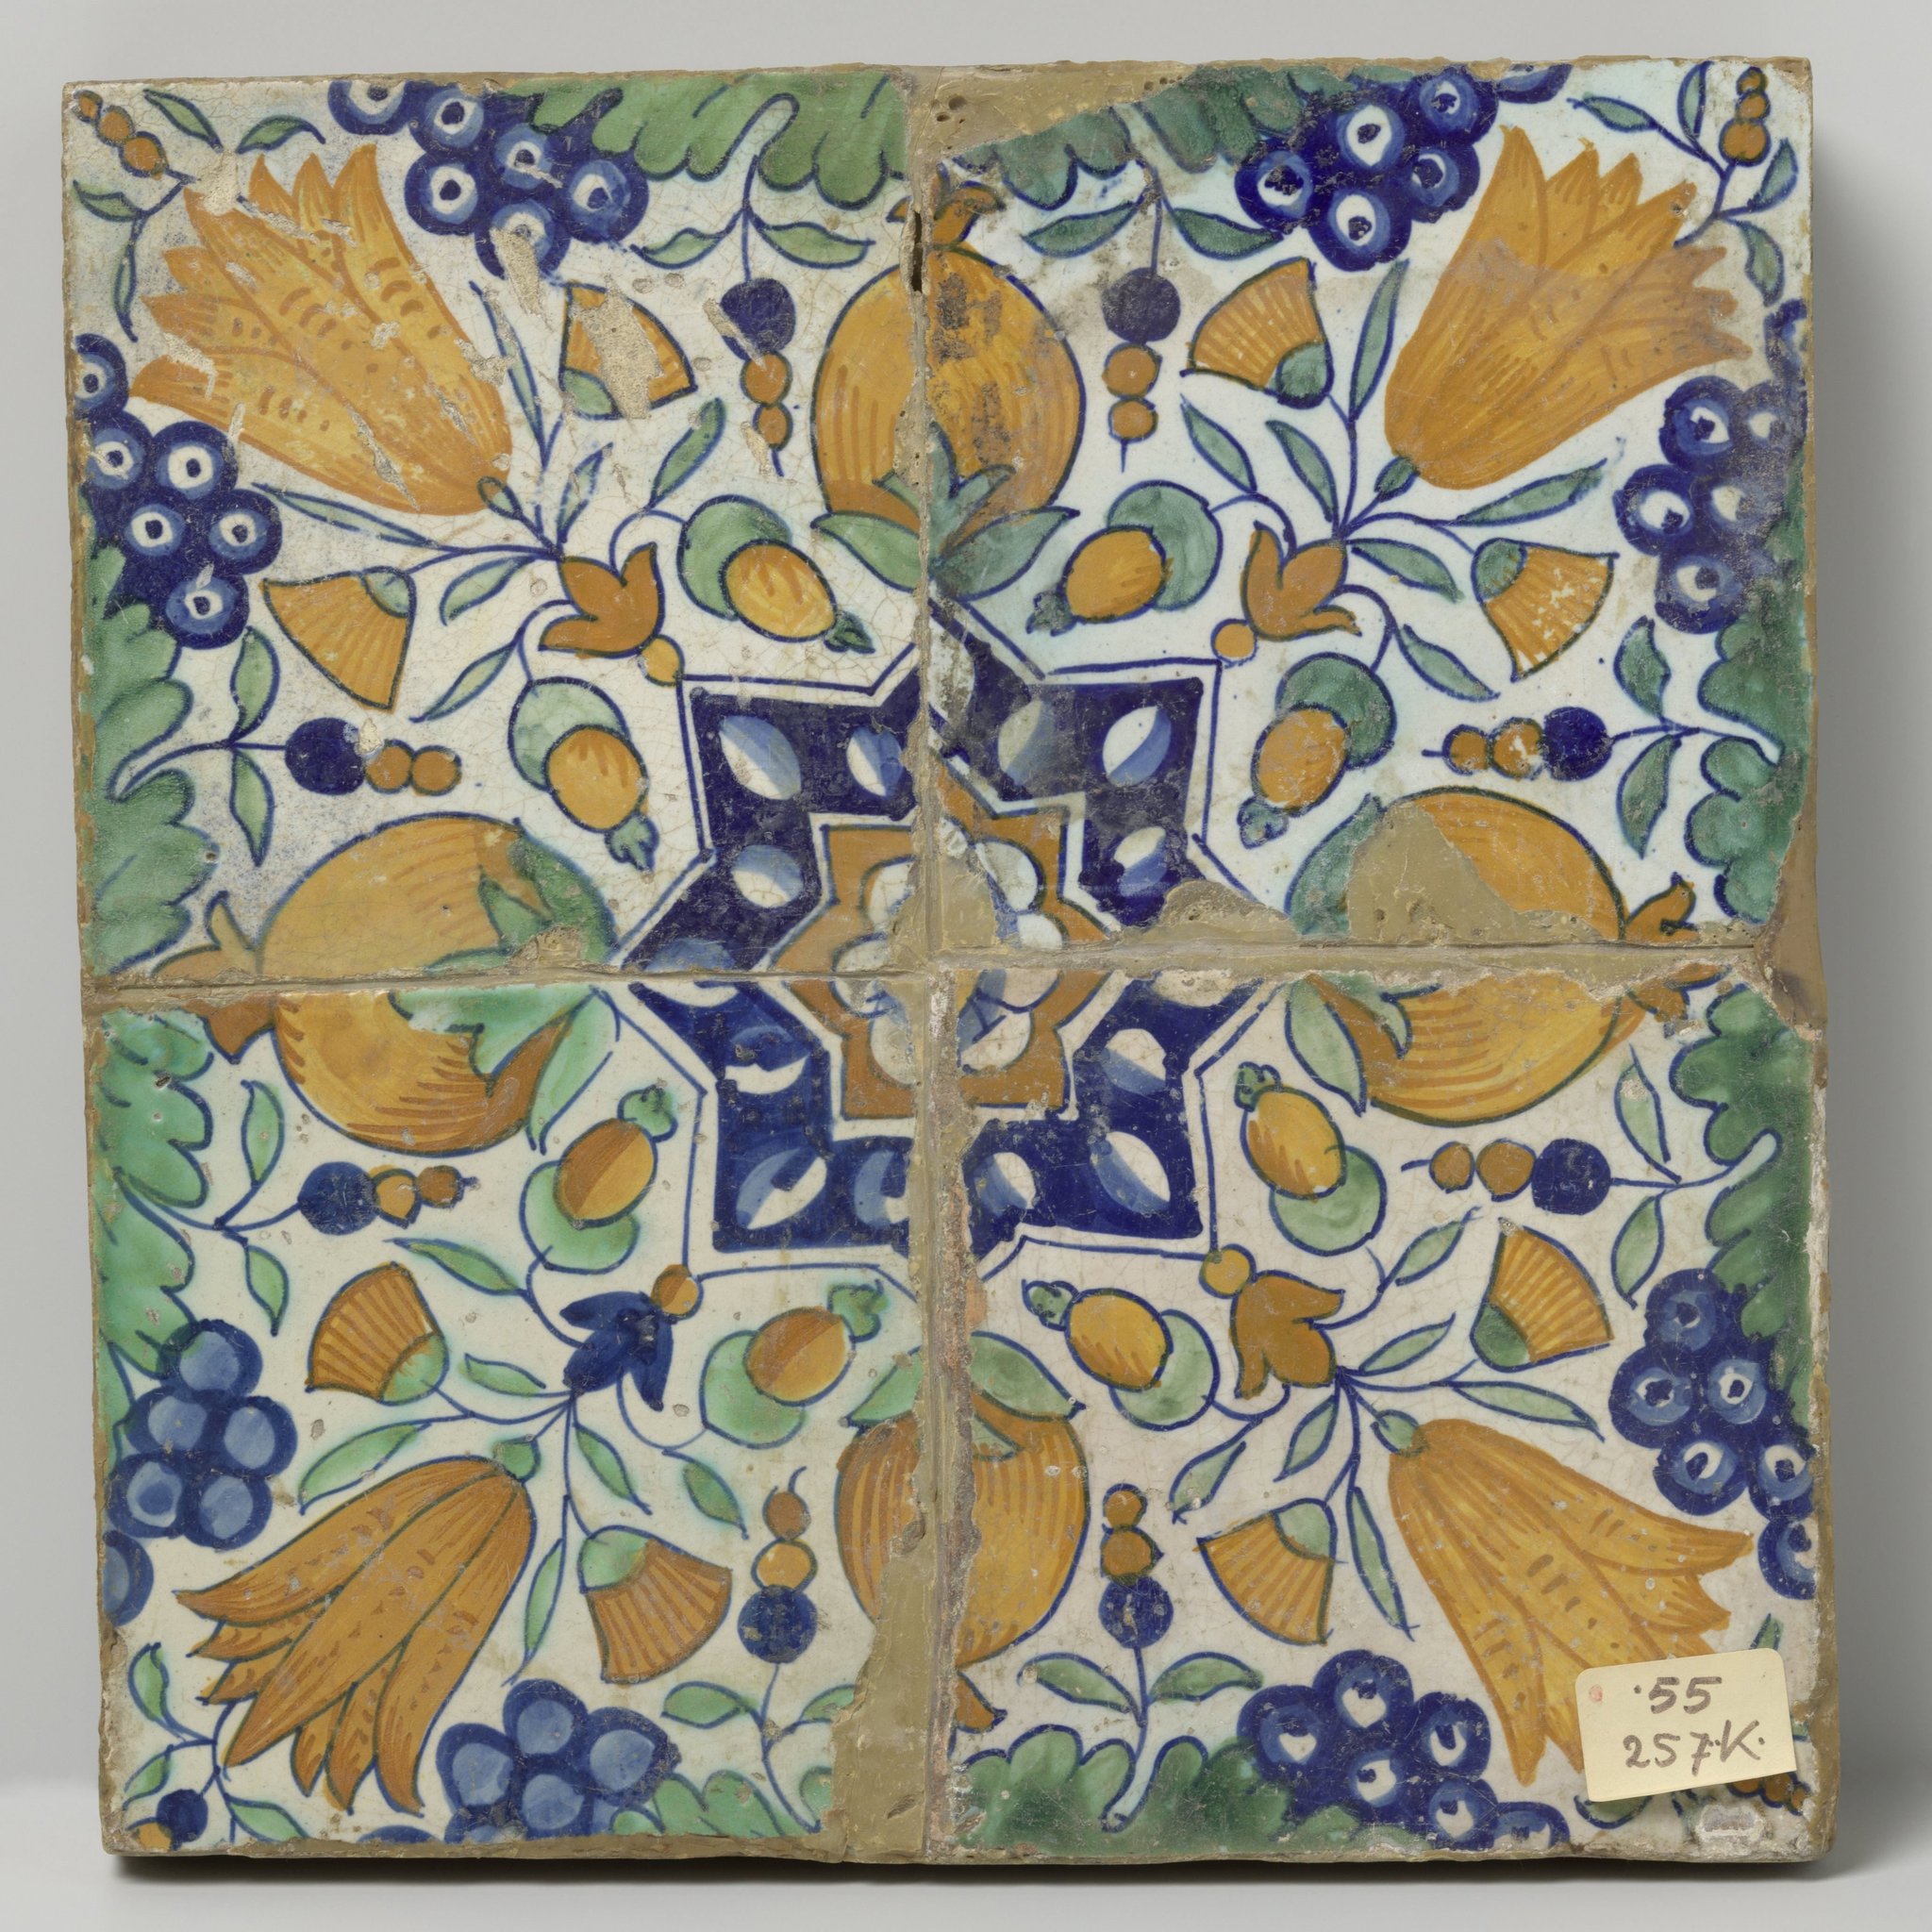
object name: tile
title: Veld van vier tegels met patroon van druiventrossen, tulpen, granaatappels en sterren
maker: Anonymous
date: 1600-1625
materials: earthenware, glaze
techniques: maiolica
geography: netherlands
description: Veld van vier tegels (2 x 2) met een veelkleurig (blauw, groen, geel, oranje en paars) patroon gevormd door vier tegels met granaatappels, druiventrossen en tulpen rond een ster.